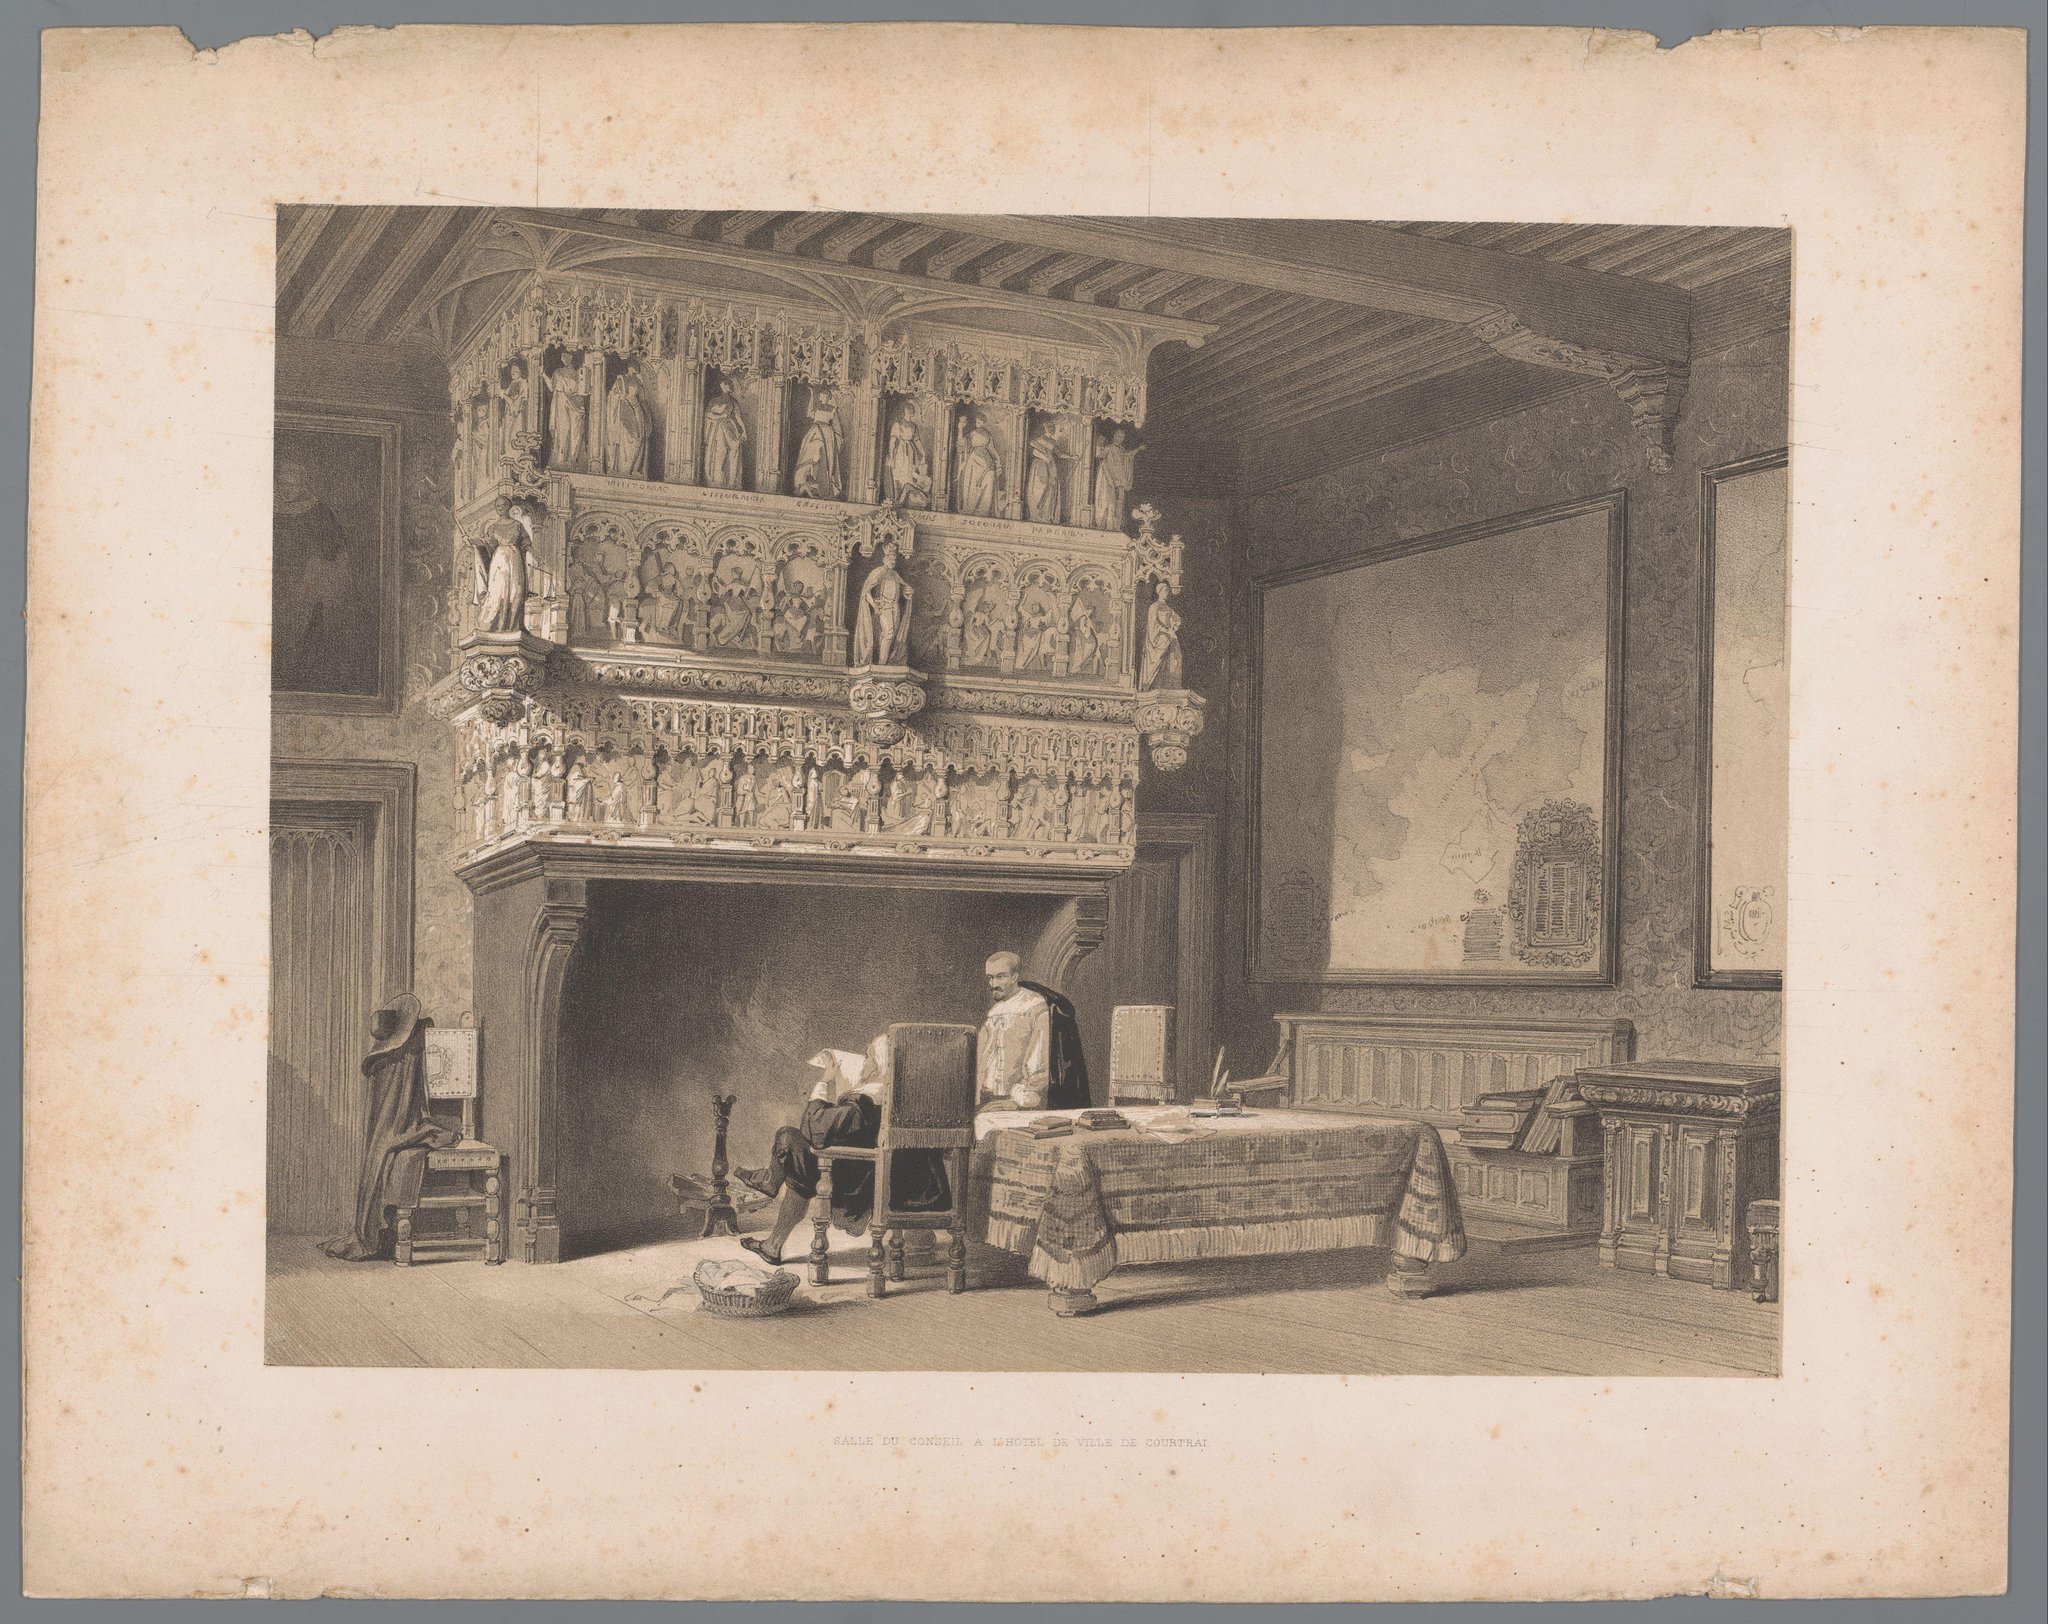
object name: print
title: Raadskamer van Kortrijk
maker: Anonymous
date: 1800-1899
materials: paper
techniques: tone lithography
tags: city council, townhall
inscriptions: collector's mark: Lugt 2228